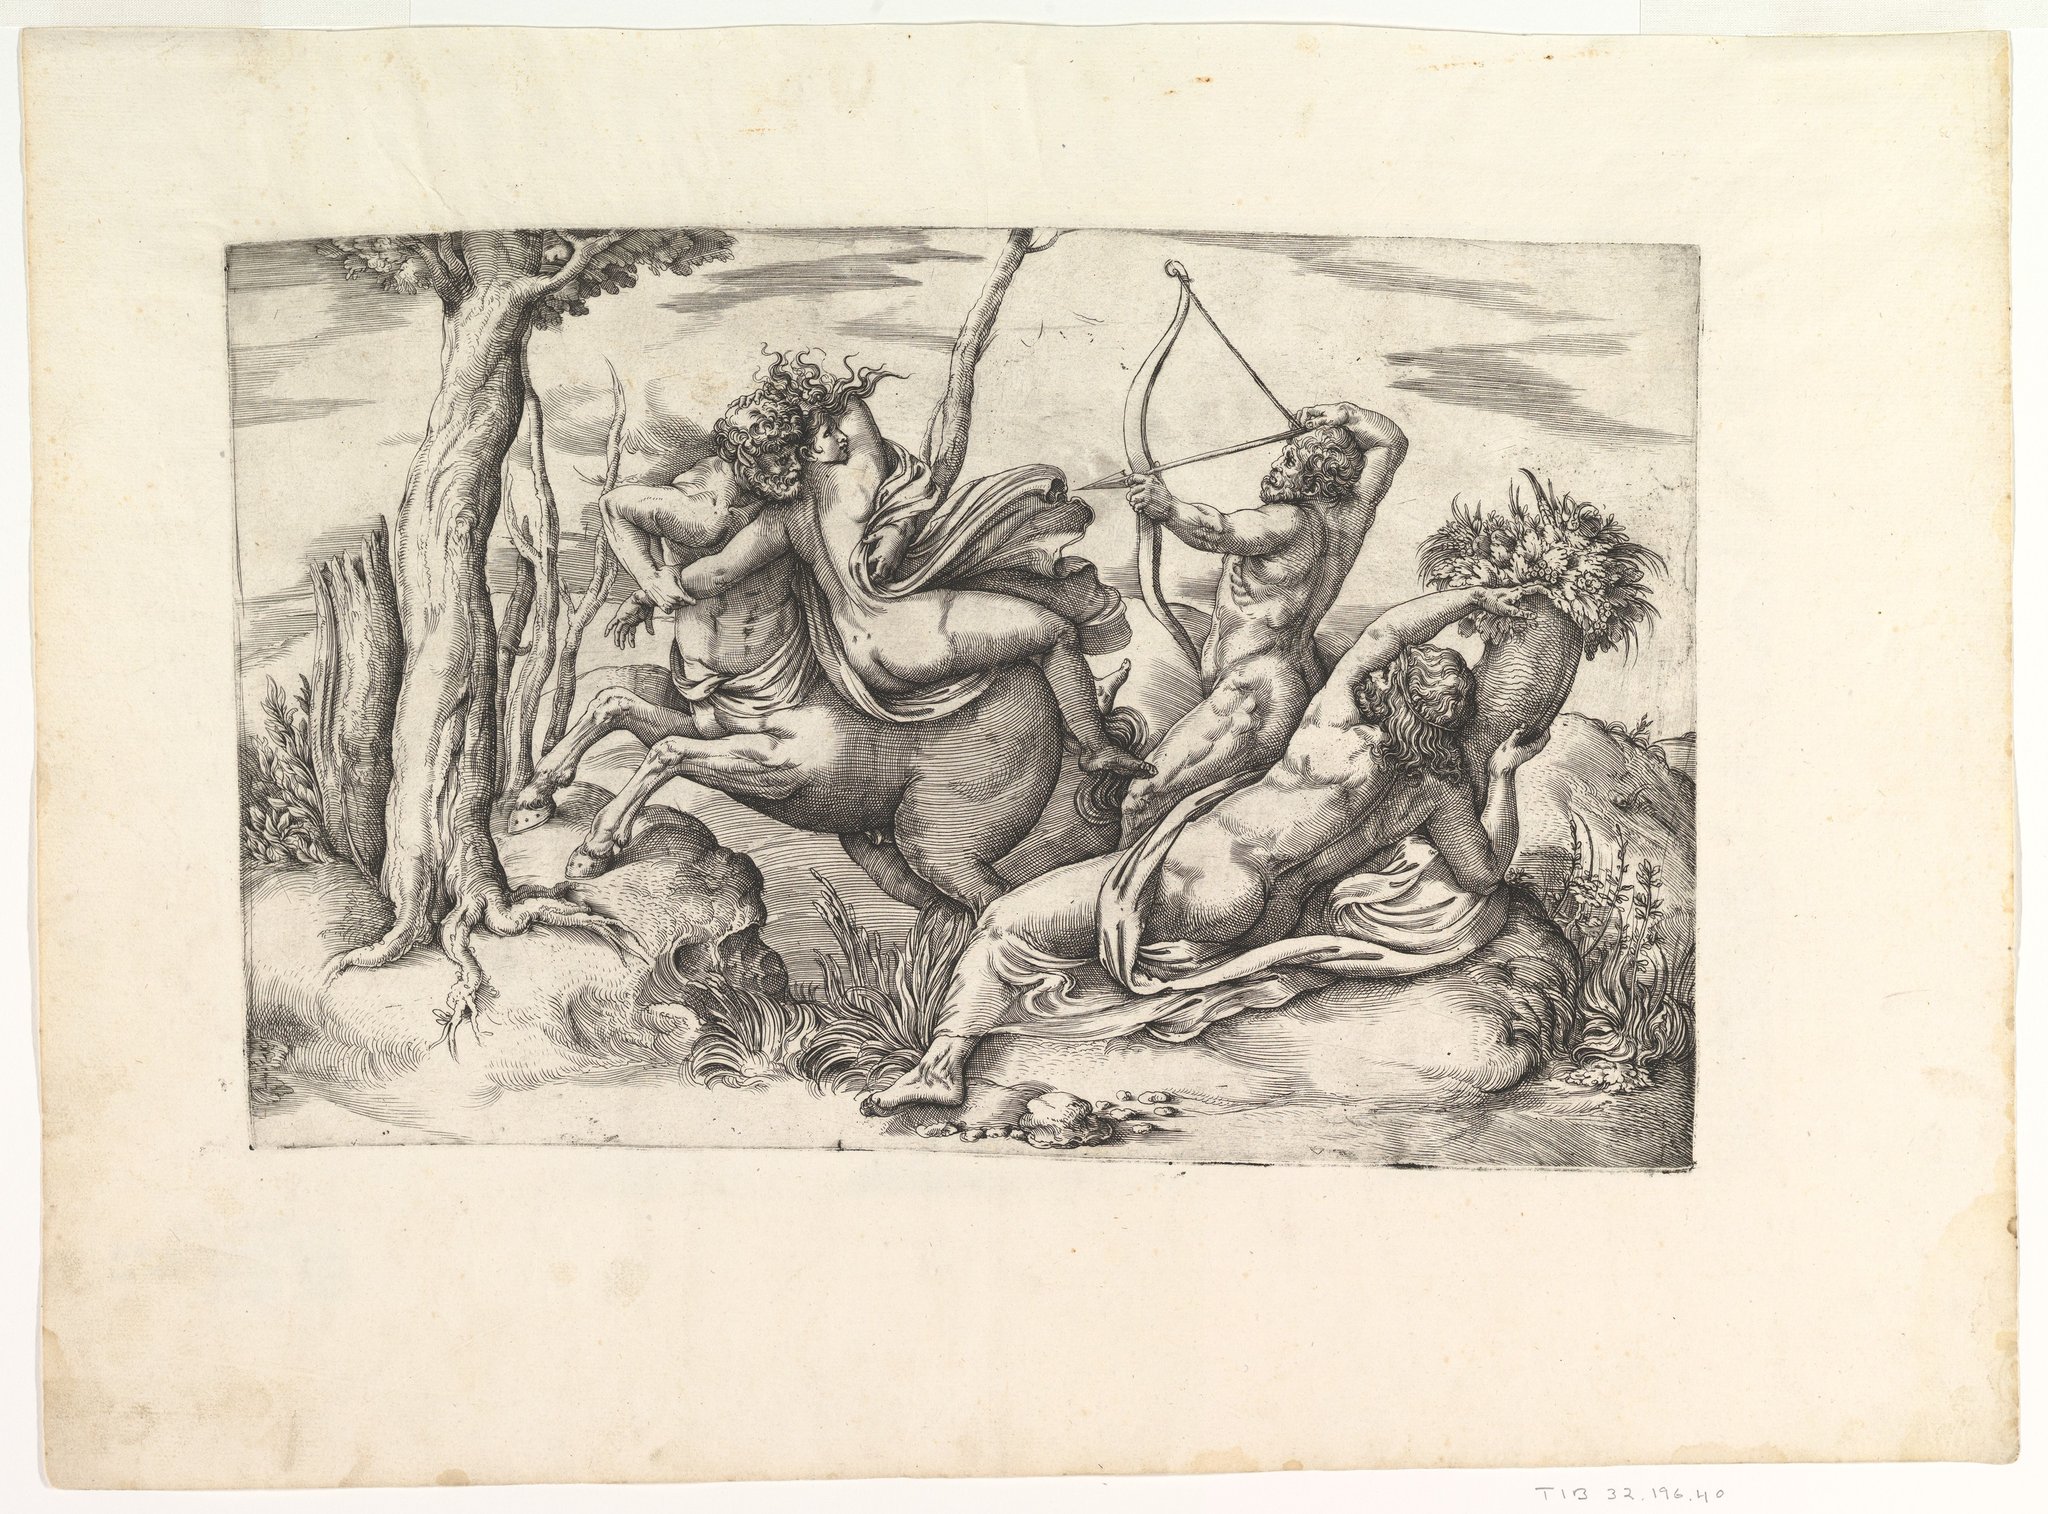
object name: print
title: The Abduction of Dejanira, at center in the arms of the centaur Nessus, Hercules at right shooting the centaur with an arrow, Achelous reclining with his cornucopia at lower right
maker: battista franco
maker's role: artist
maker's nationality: italian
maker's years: 1510-1561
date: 1530-1561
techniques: etching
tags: bow and arrow,hercules,centaurs,cornucopia,trees